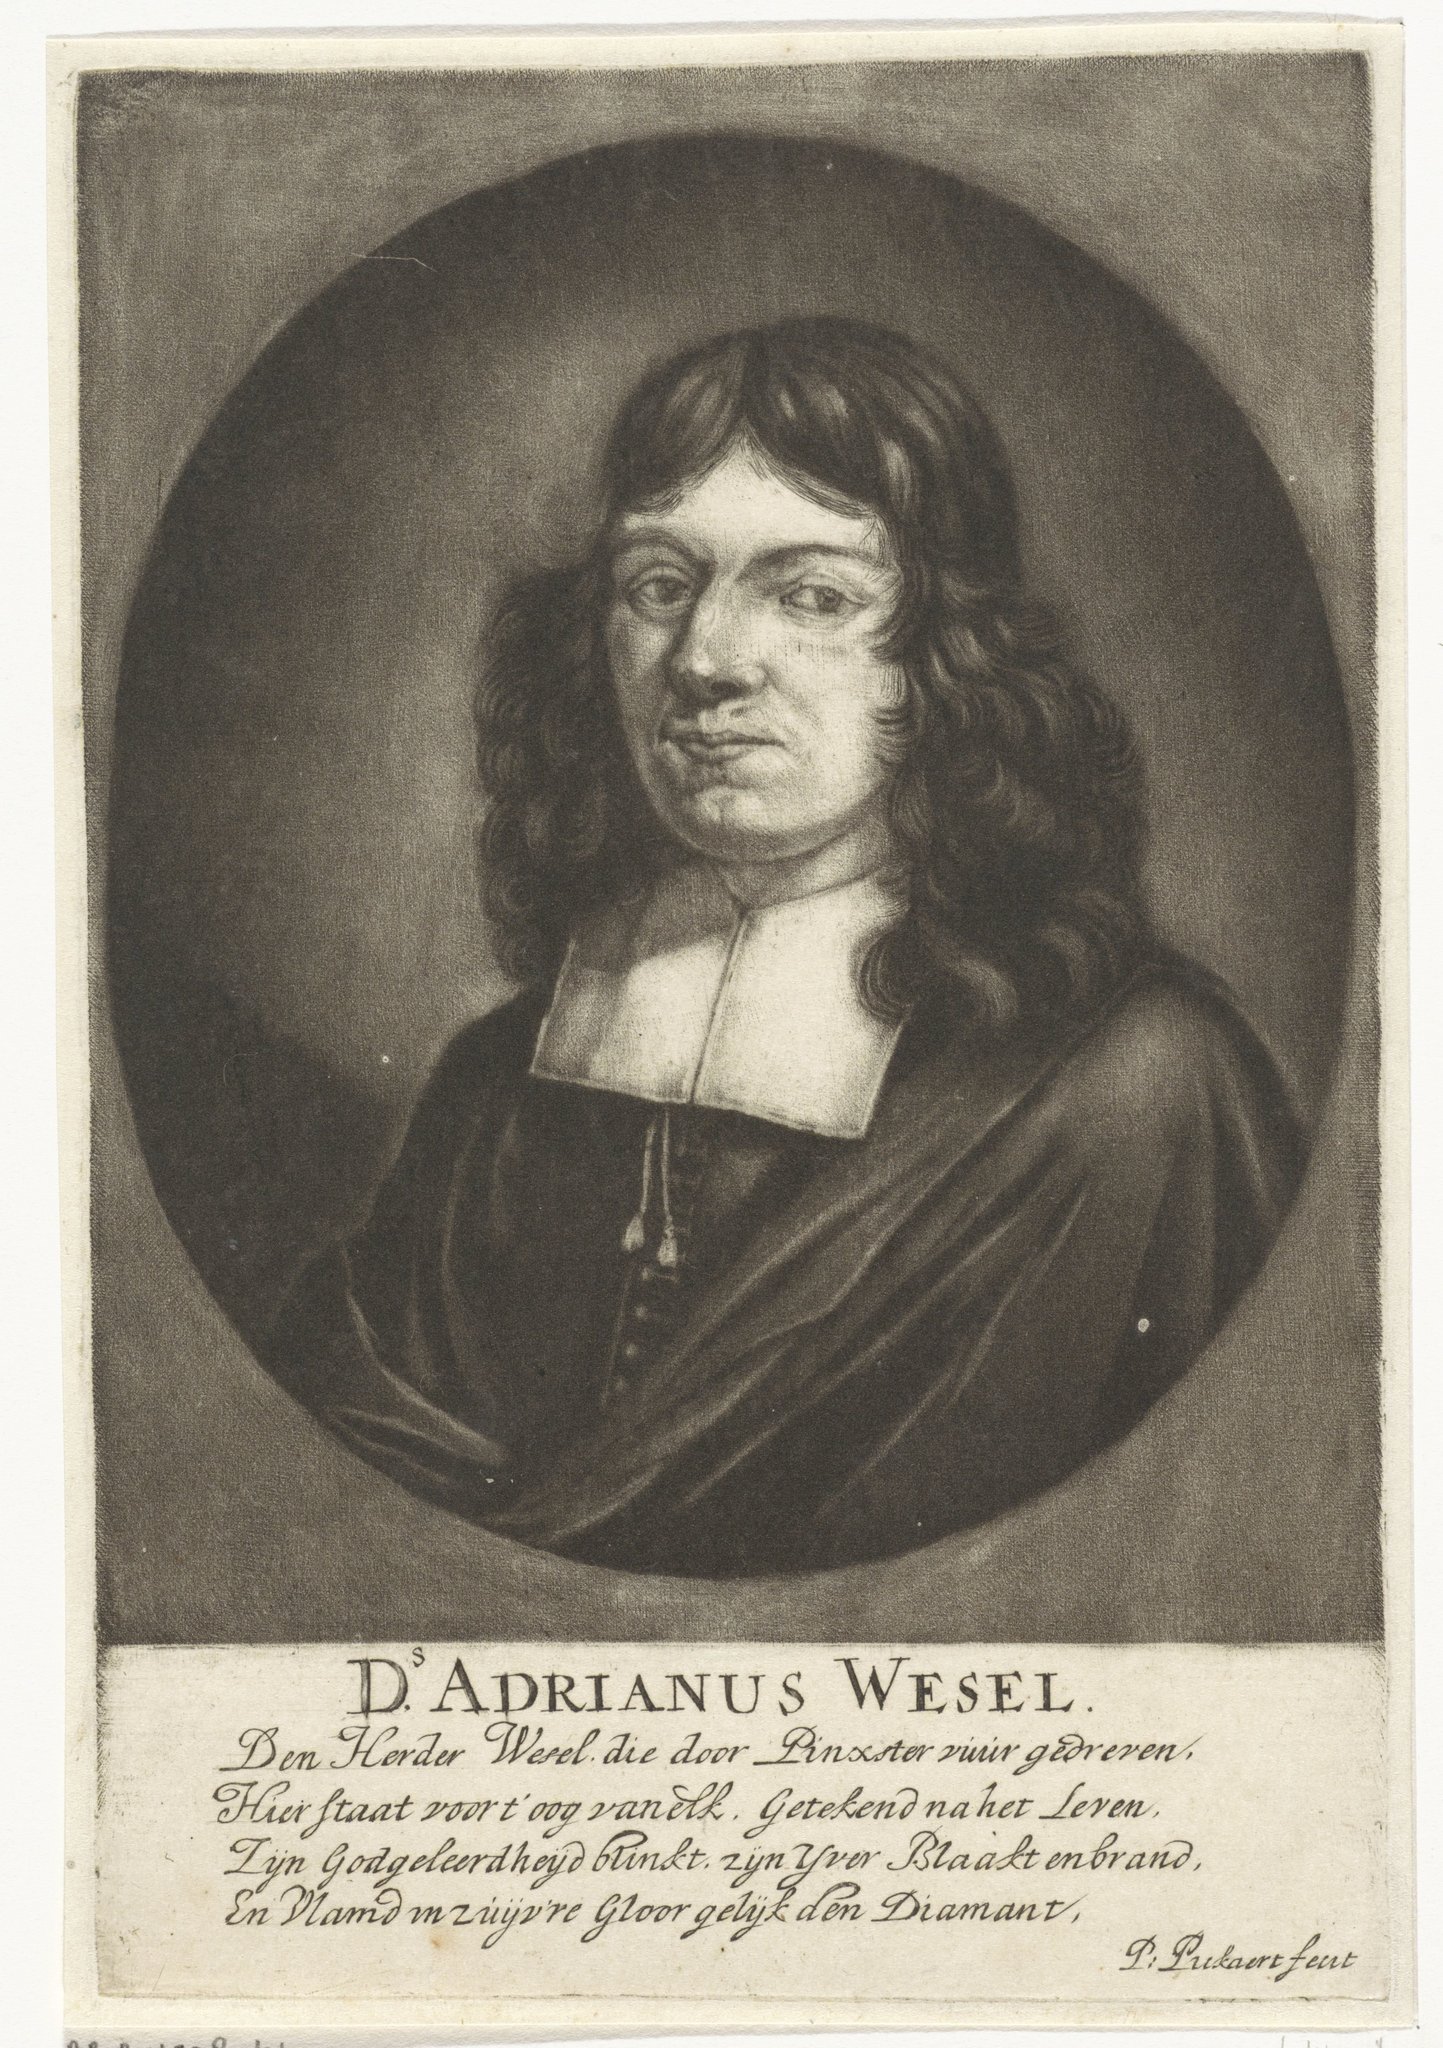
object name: print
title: Portret van Adriaan Wesel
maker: pieter pickaert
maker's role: print maker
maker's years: 1668-1737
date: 1680-1715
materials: paper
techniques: engraving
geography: amsterdam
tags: predikant, theoloog, adriaan wesel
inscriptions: collector's mark: Lugt 2228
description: Adriaan Wesel, predikant in verschillende steden, waaronder Amsterdam.